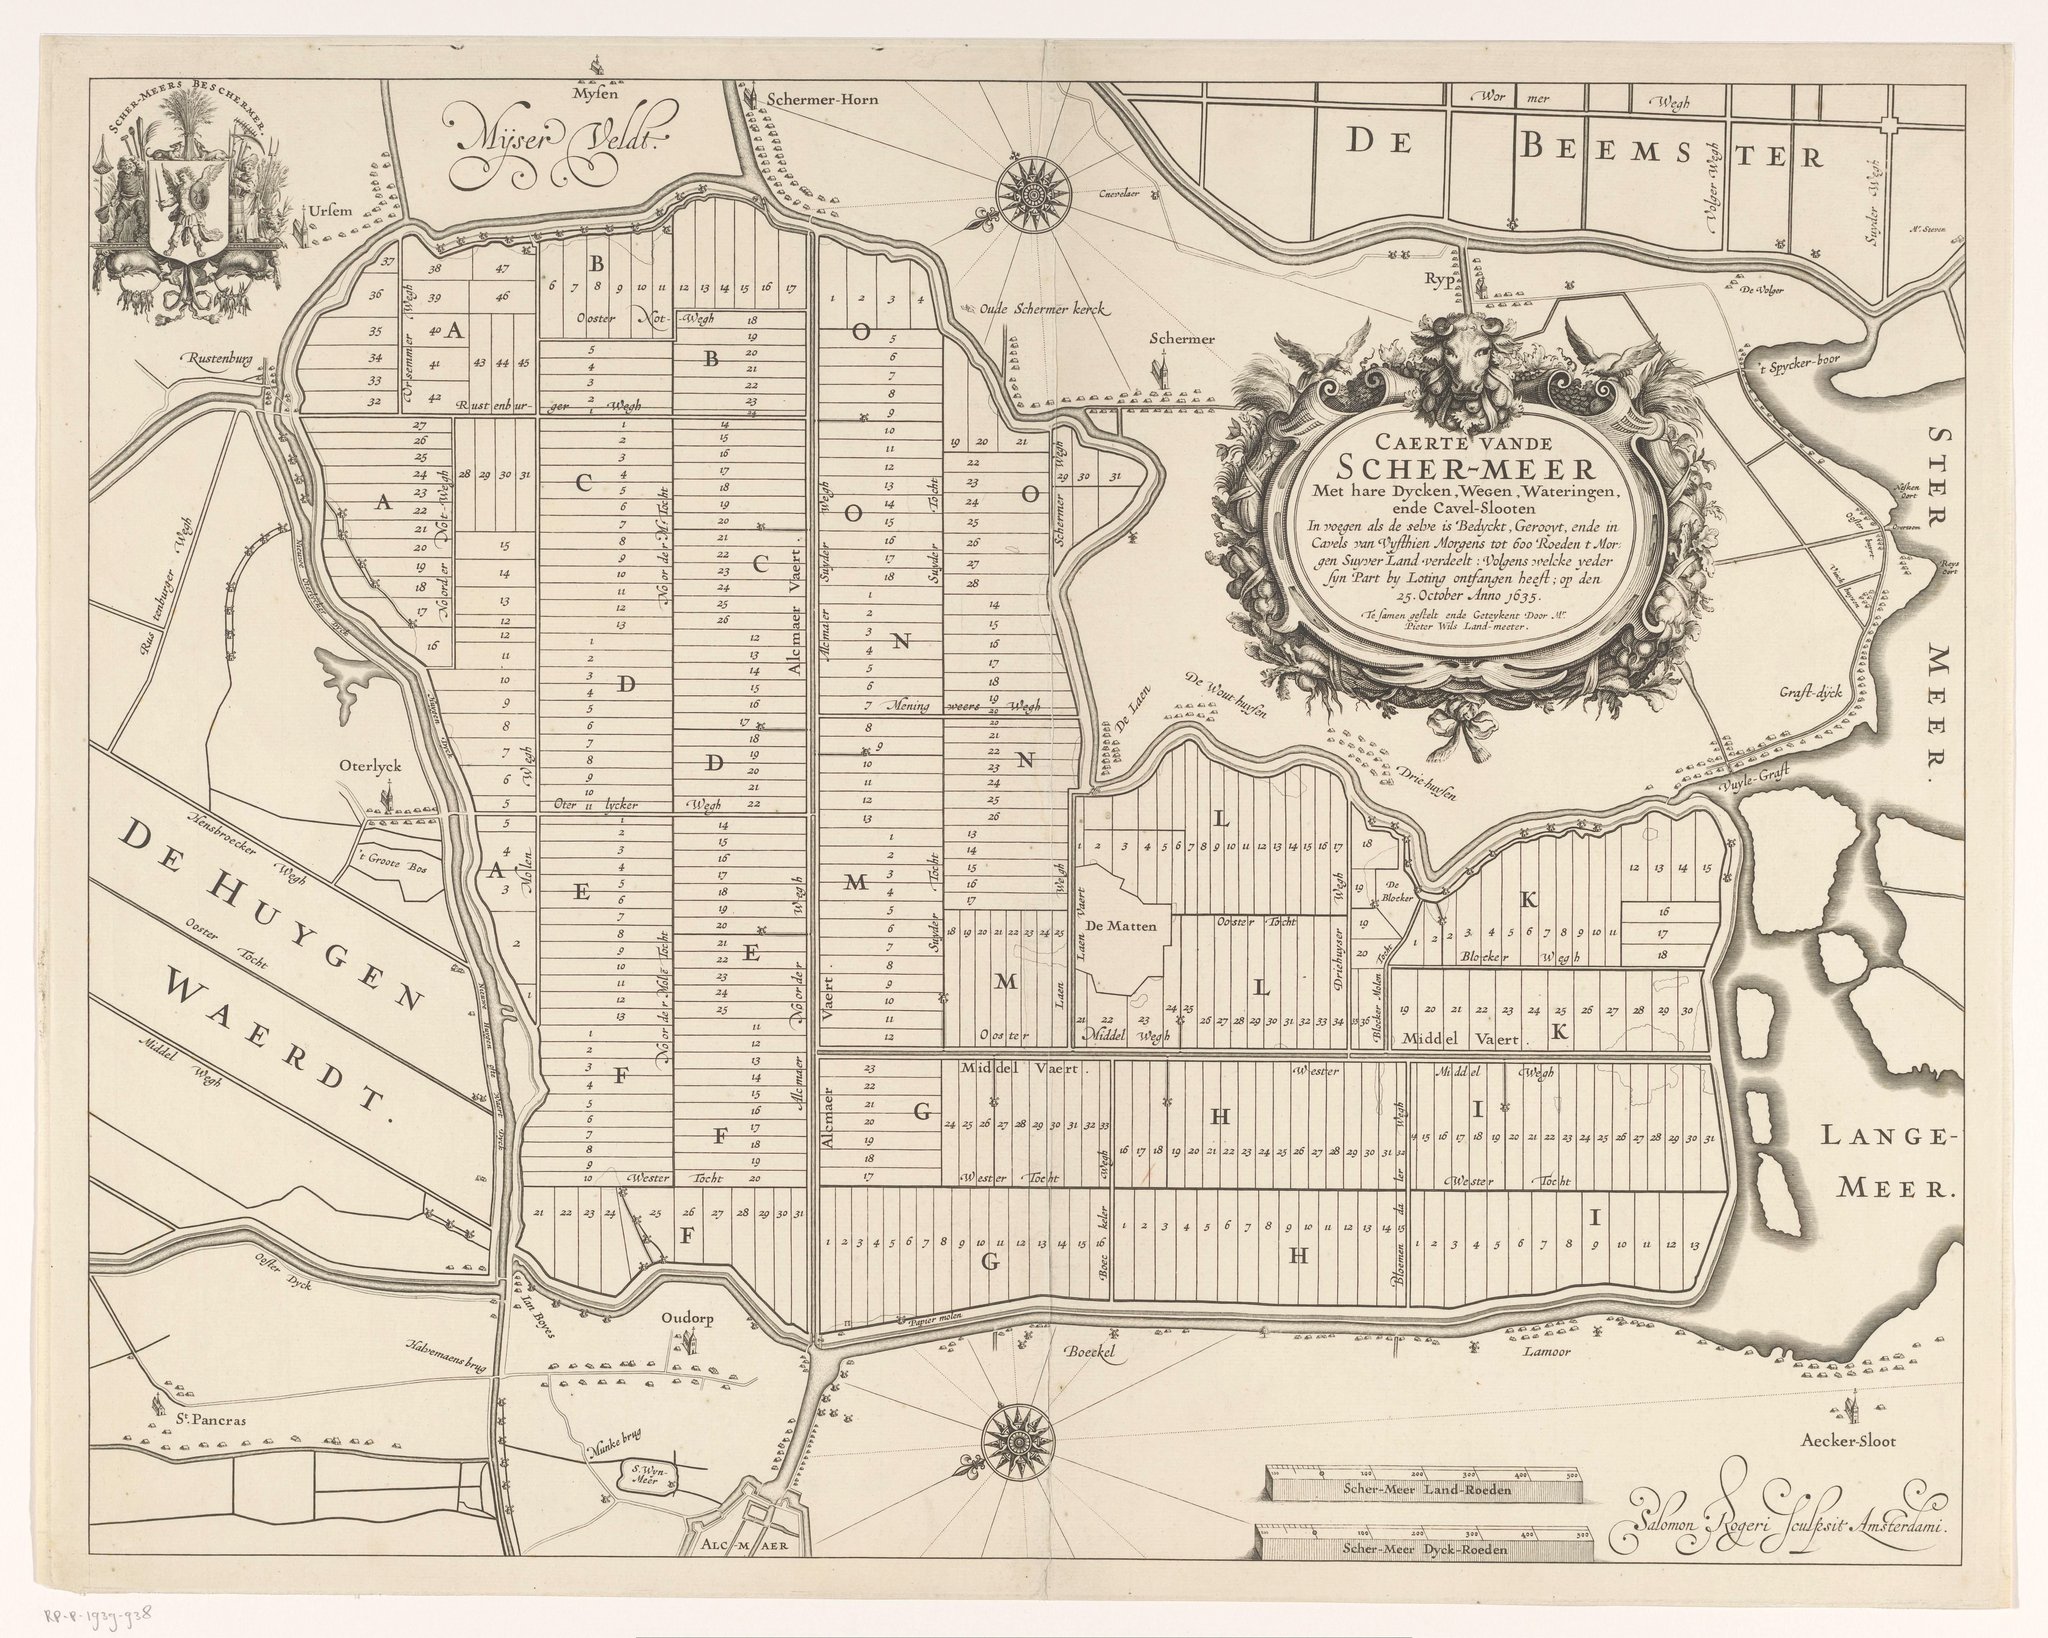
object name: map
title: Caerte vande Scher-meer met hare dycken, wegen, wateringen ende cavel-slooten …Volgens welcke yeder syn part by loting ontfangen heeft; op den 25. october anno 1635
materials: paper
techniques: engraving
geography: amsterdam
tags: coat of arms (as symbol of the state, etc.), maps of separate countries or regions, polder, reclaimed land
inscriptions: collector's mark: Lugt 2760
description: Kaart van de Schermerpolder na voltooiing van de bedijking en verloting van de kavels op 25 oktober 1635. Linksboven een wapen met een beschermengel: Scher-meers Beschermer (mogelijk het toenmalige wapen van de polder). Rechtsboven de titelcartouche. Rechtsonder twee schaalstokken: 500 Scher-Meer land-roeden; 500 Scher-Meer dyck-roeden.